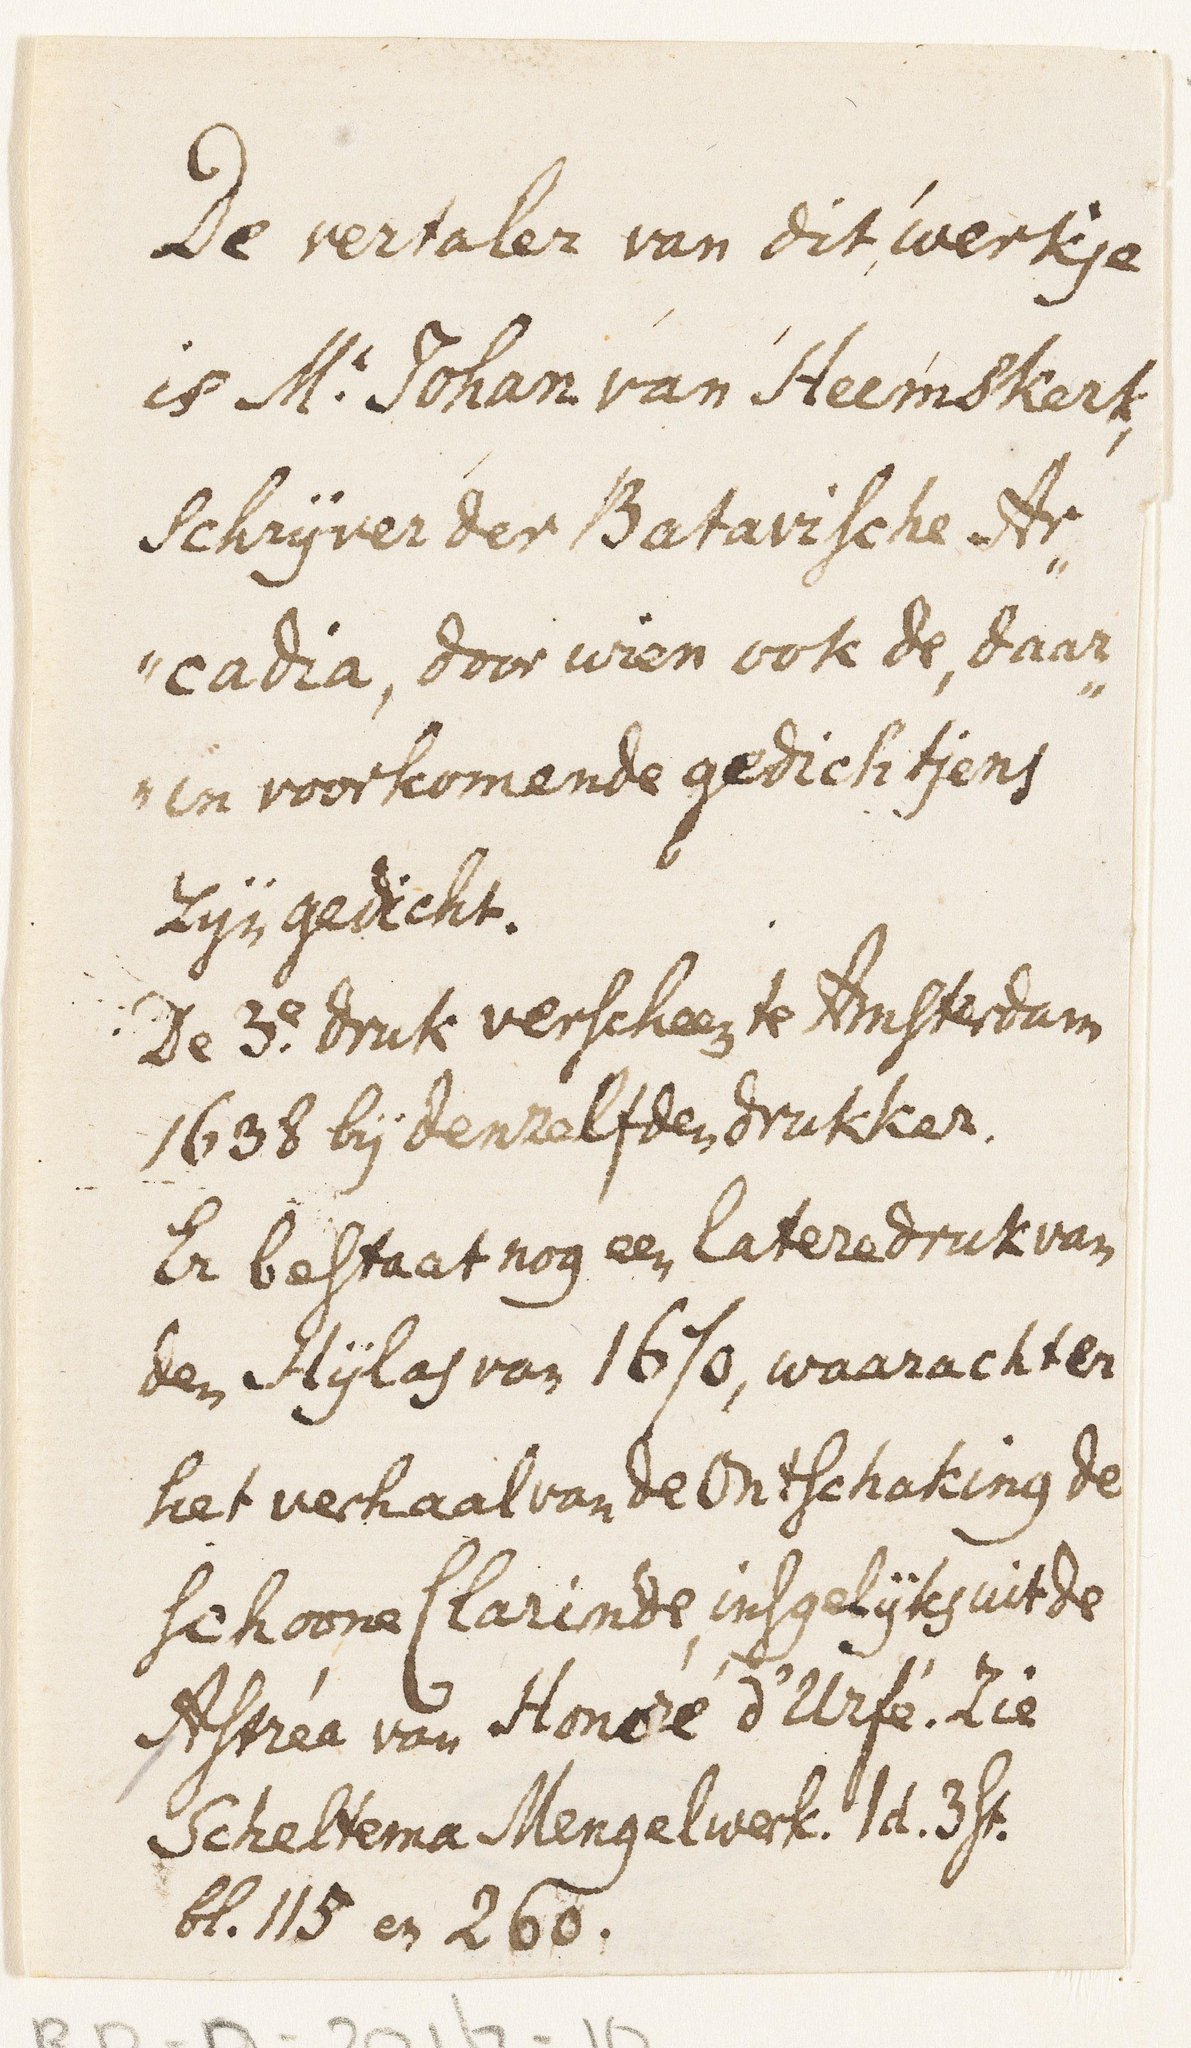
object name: document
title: Handgeschreven tekst over inhoud van een boek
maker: Anonymous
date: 1800-1900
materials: ink, paper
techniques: pen, writing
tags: handwriting, written text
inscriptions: collector's mark: Lugt 2228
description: Tekst over het boek Den ongestadigen Hylas, De veranderlijcke Stella, De lichtveerdige Pamphilus, 1636.